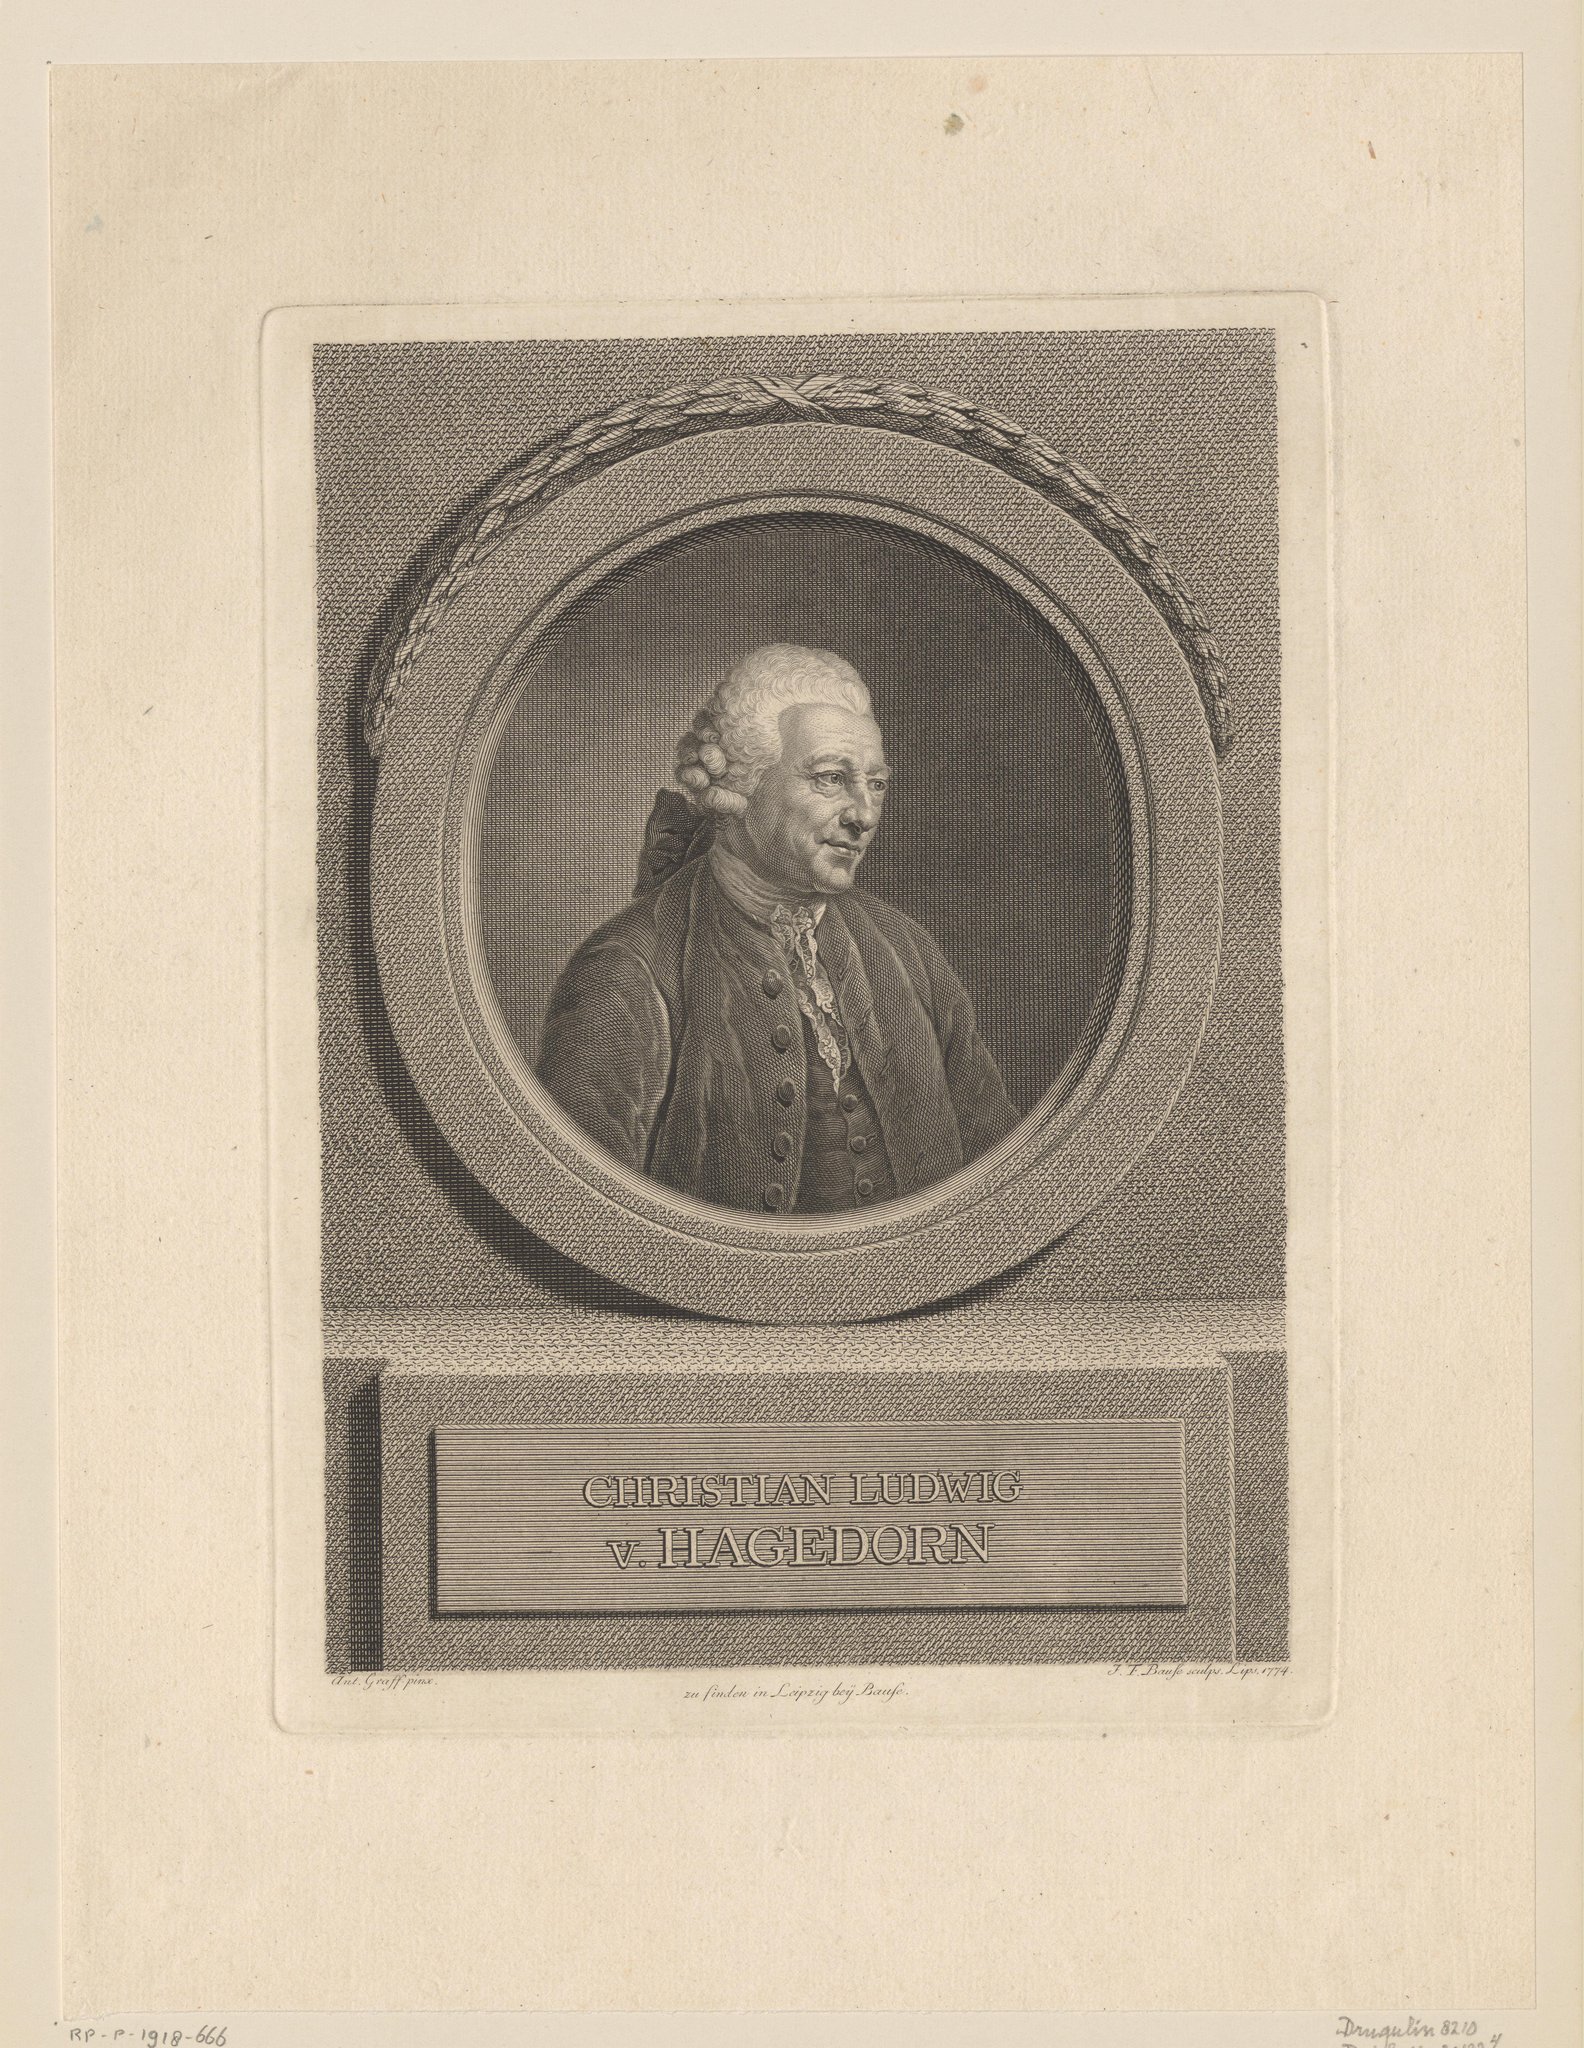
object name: print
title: Portret van Christian Ludwig von Hagedorn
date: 1774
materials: paper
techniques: engraving, etching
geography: leipzig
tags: painter, christian ludwig von hagedorn, historical persons, portrait, self-portrait of artist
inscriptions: collector's mark: Lugt 2233